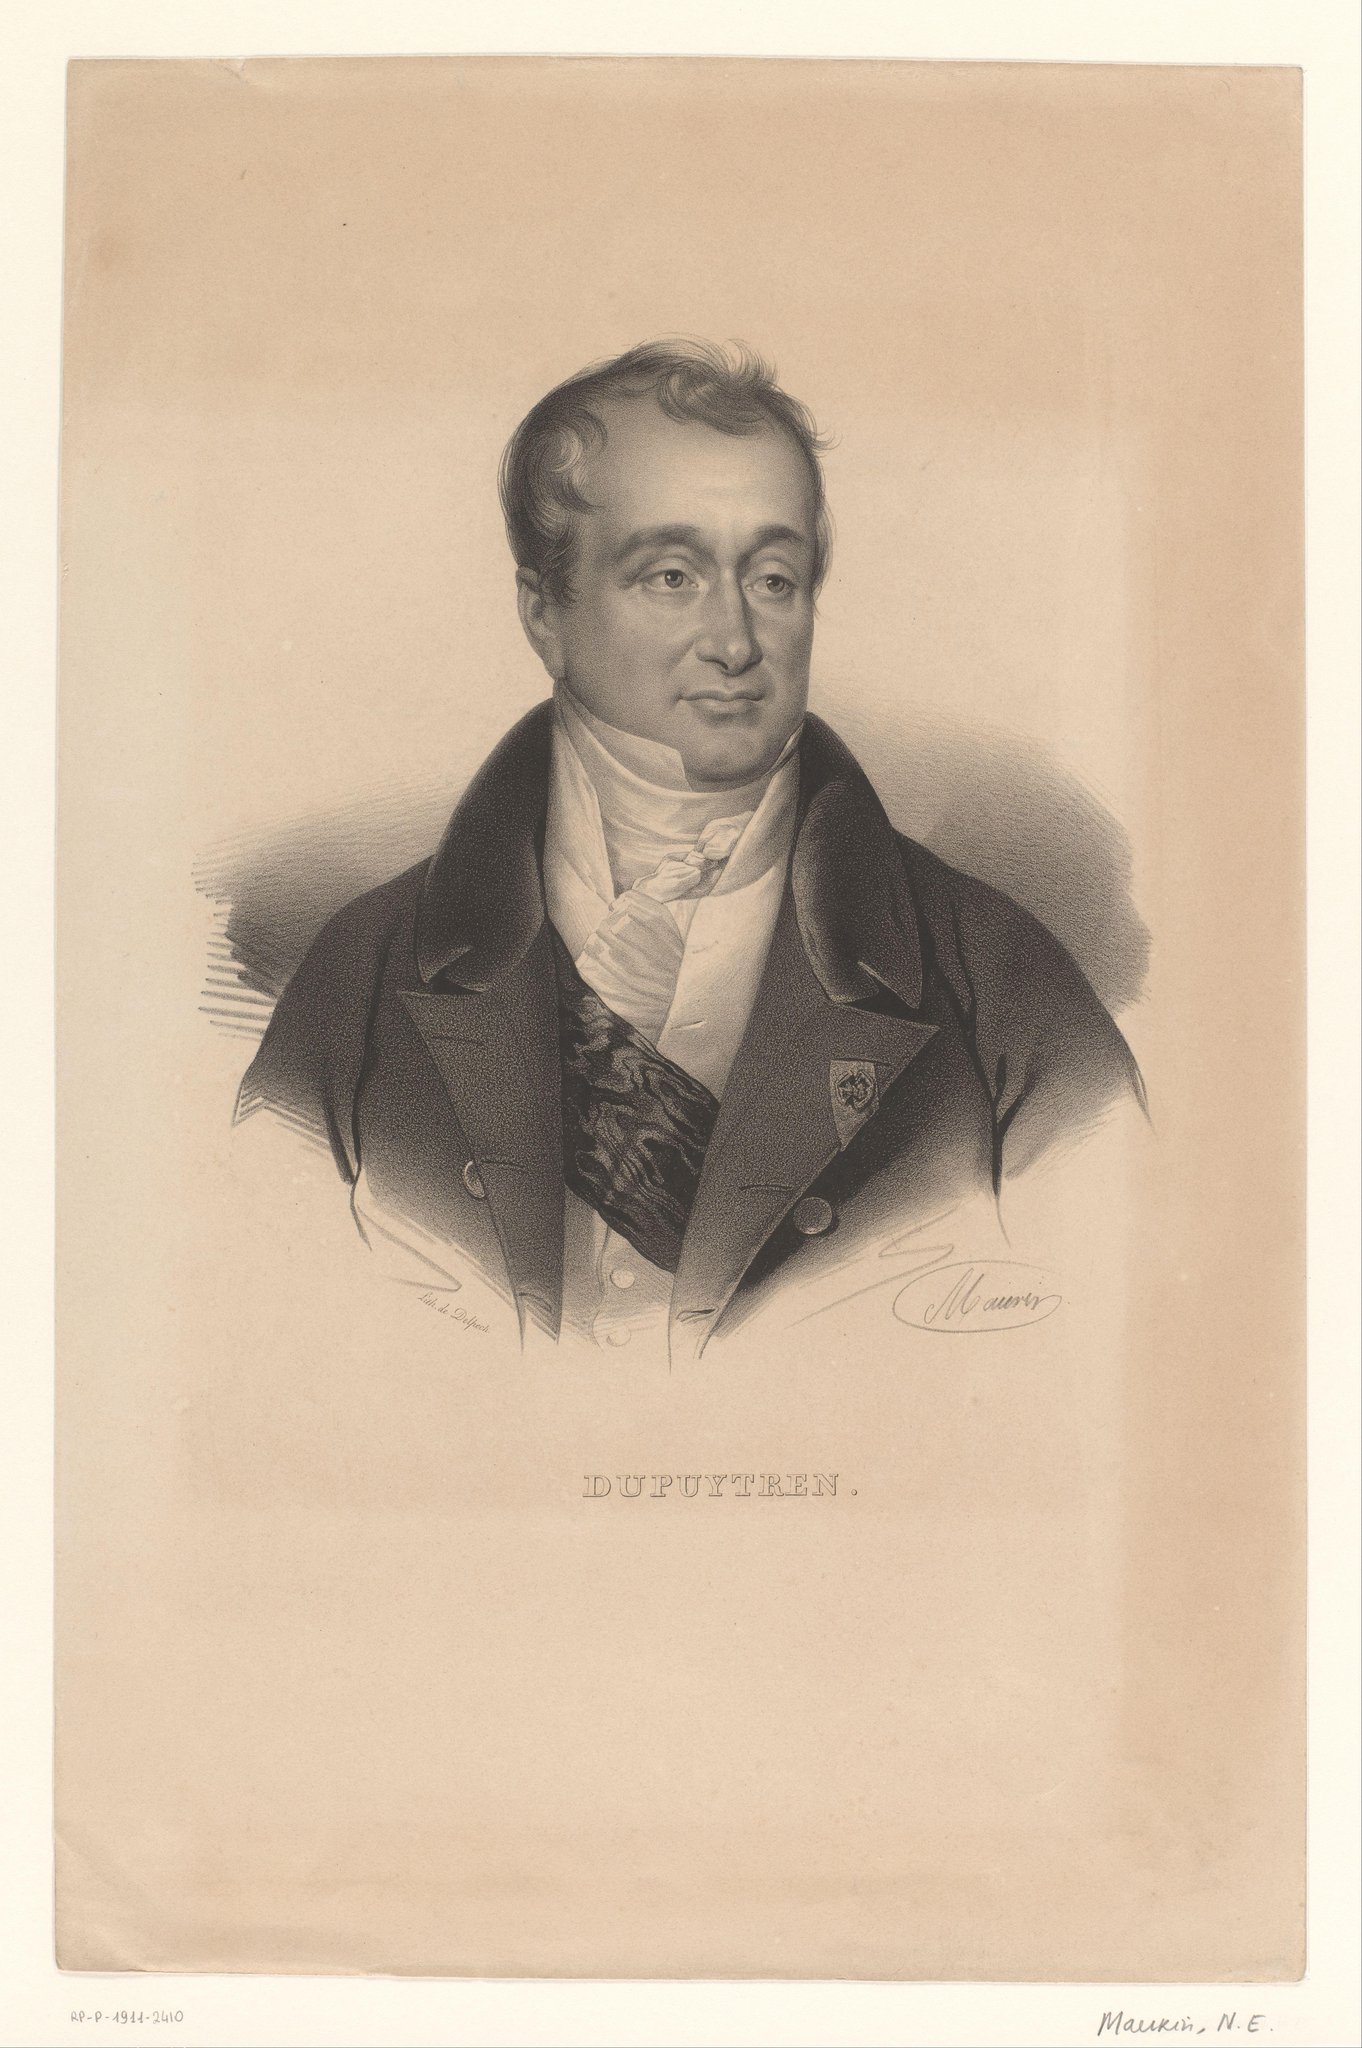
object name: print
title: Portret van arts Guillaume Dupuytren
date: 1825-1842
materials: paper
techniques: lithograph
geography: paris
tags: historical persons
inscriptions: collector's mark: Lugt 2228